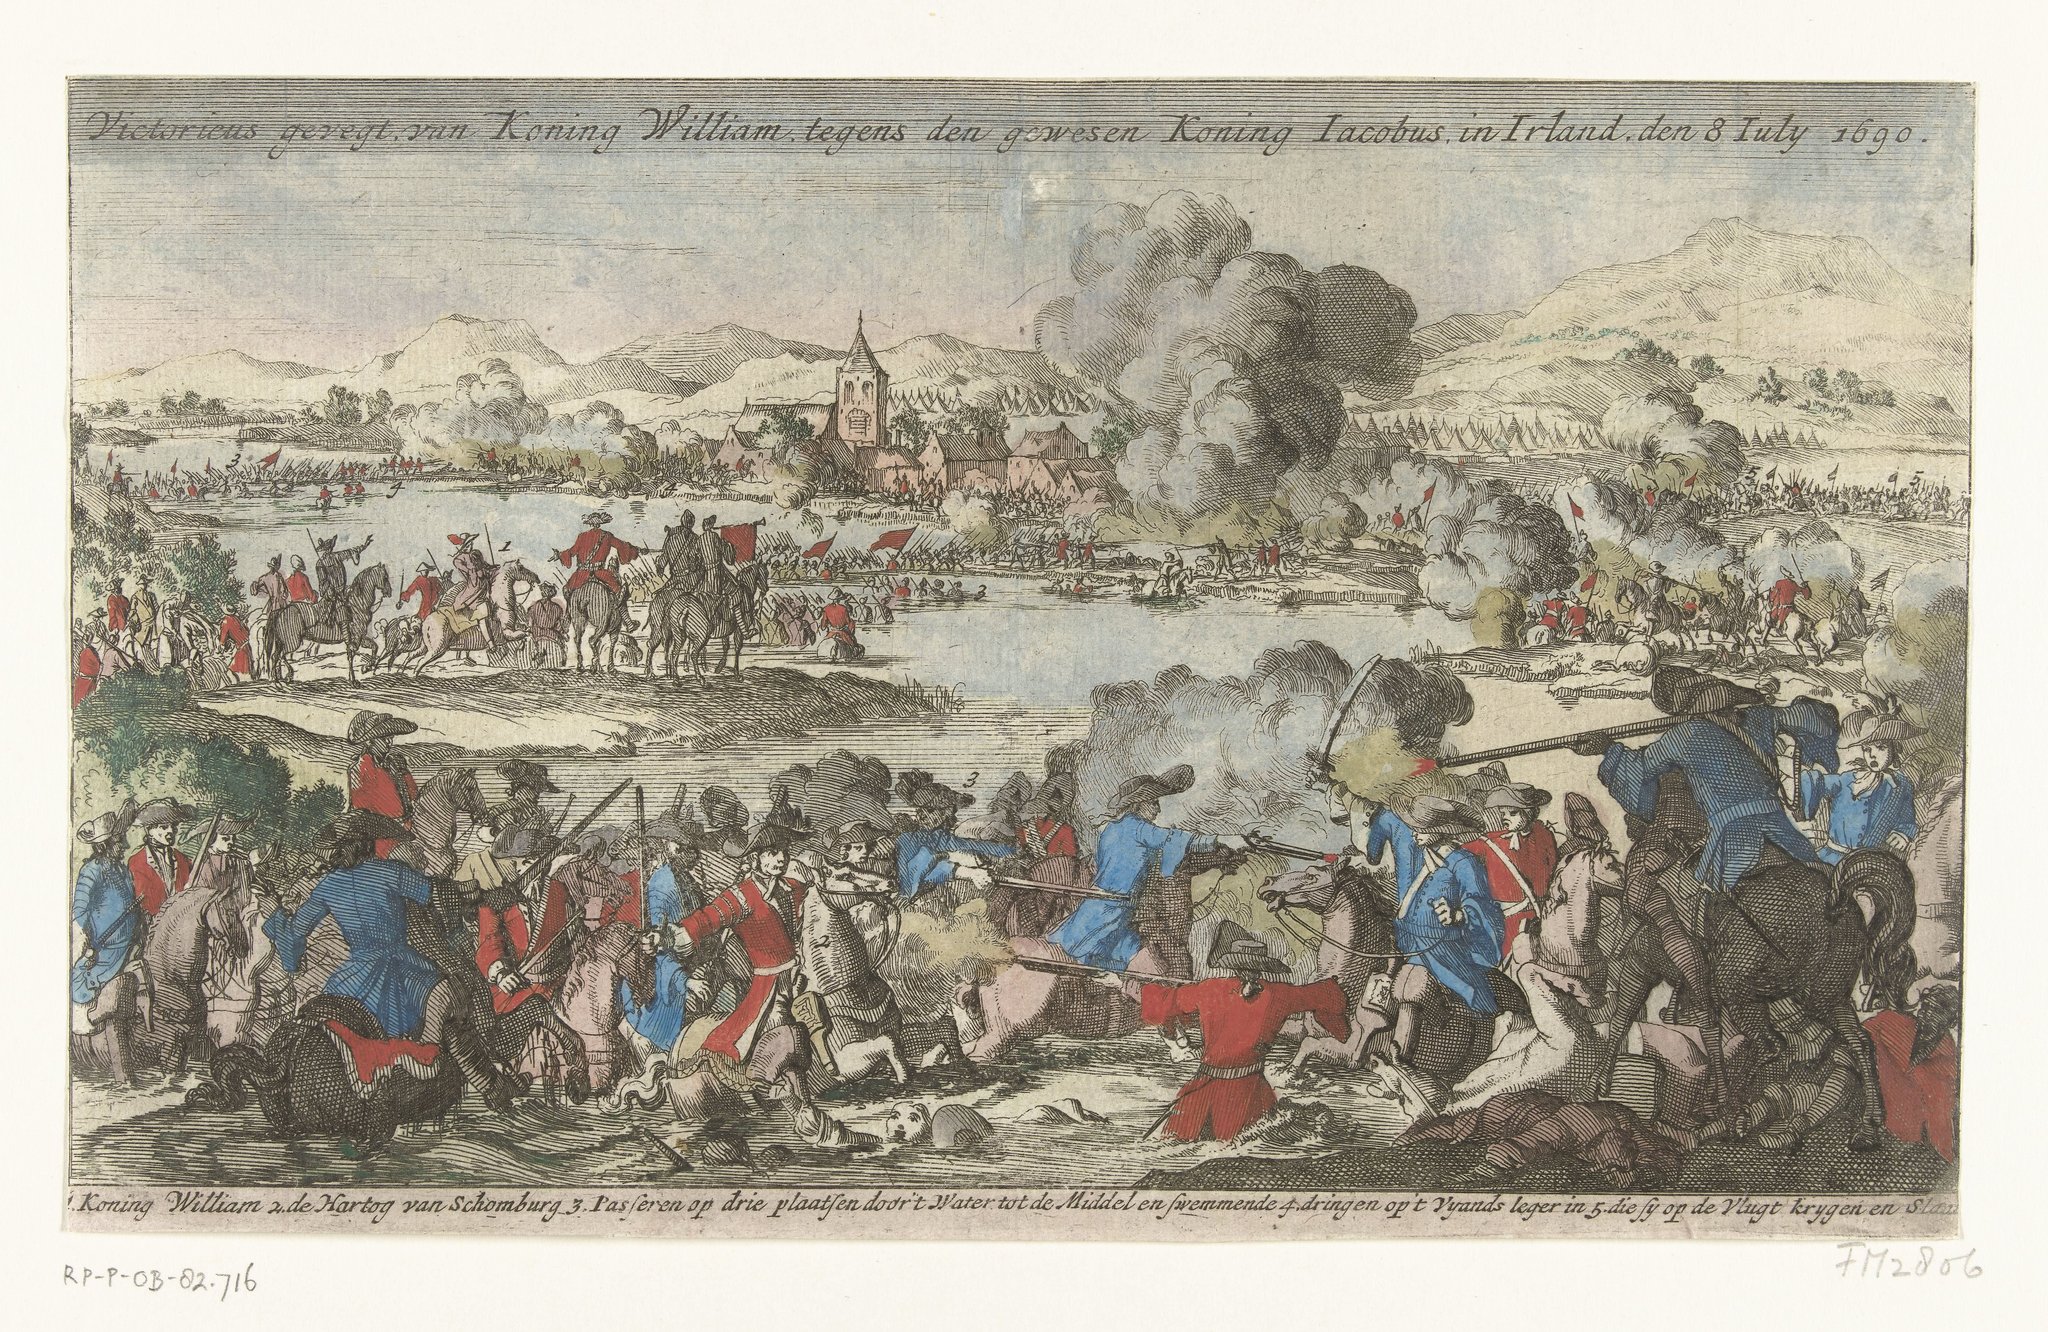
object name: print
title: Slag aan de Boyne, 1690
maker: Anonymous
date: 1692-1694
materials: paper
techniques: etching, hand coloring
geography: northern netherlands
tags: the hague, william iii (prince of orange and king of england, scotland, and ireland), battle (+ land forces)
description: Slag bij de rivier de Boyne op 11 juli 1690, waarbij het leger van Willem III en overwinning behaalt op de katholieken onder Jacobus II. In het midden de hertog van Schomberg te paard die in de slag zou sneuvelen. In het onderschrift de legenda 1-5.